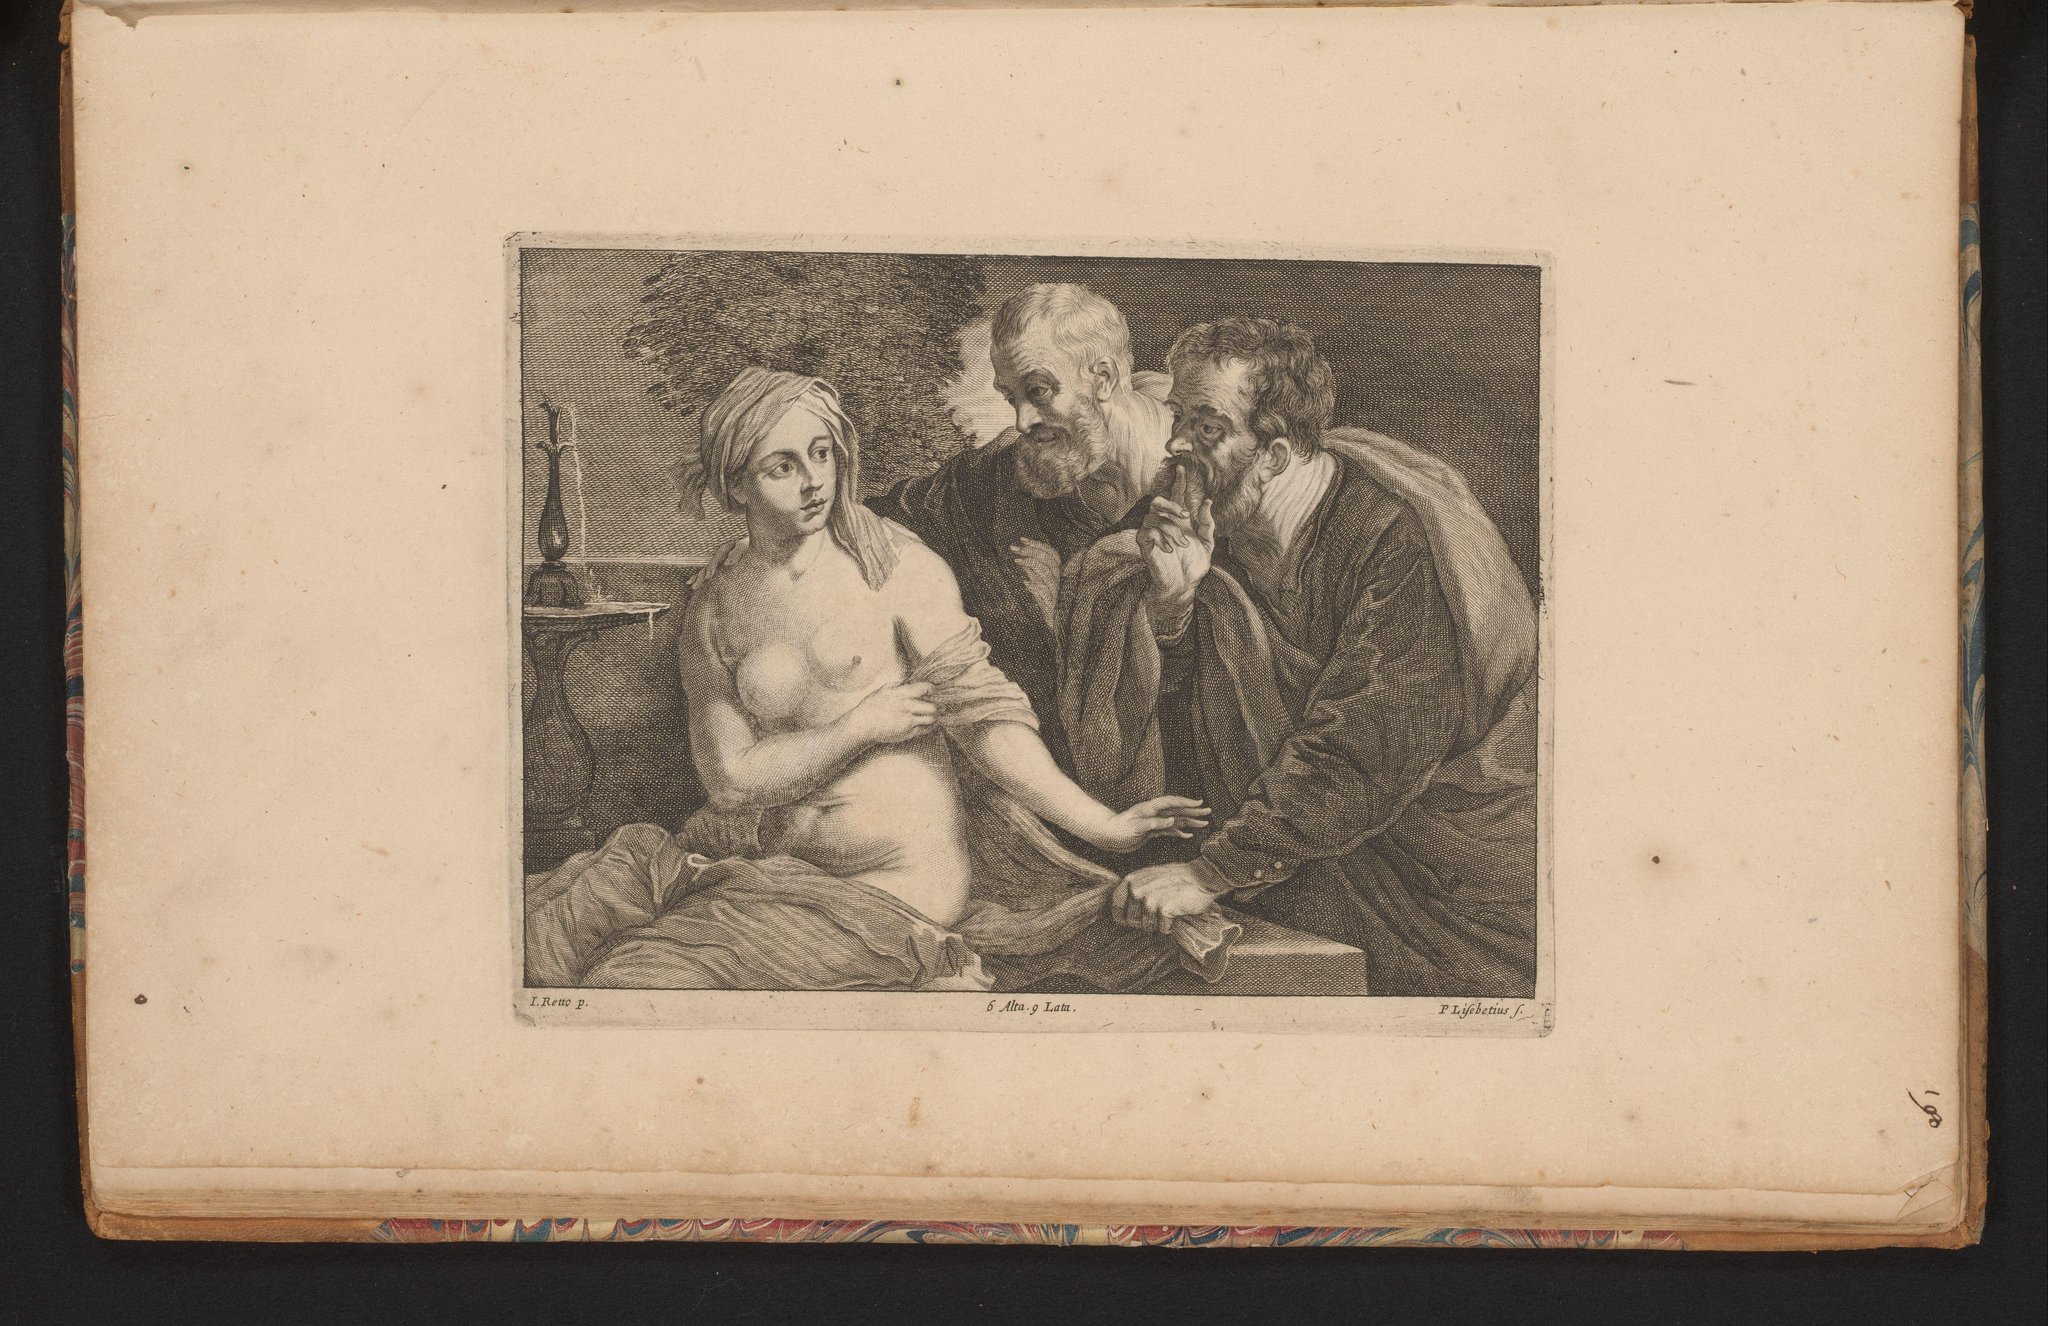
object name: album leaf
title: Susanna en de ouderlingen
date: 1660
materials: paper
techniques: engraving, etching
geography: italy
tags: the elders making advances towards susanna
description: De prent is vervaardigd naar het schilderij van Reni dat zich in de collectie van The National Gallery te Londen bevindt (inventarisnummer NG 196). David Teniers heeft waarschijnlijk van alle schilderijen uit de collectie van Leopold Willem van Oostenrijk een olieverfstudie op doek of paneel vervaardigd (zgn. pasticcio), die als voorbeeld voor de prentmakers diende. Het is niet altijd duidelijk of de pasticci door hem zijn gemaakt of door zijn atelier. Niet alle pasticci zijn overgeleverd.